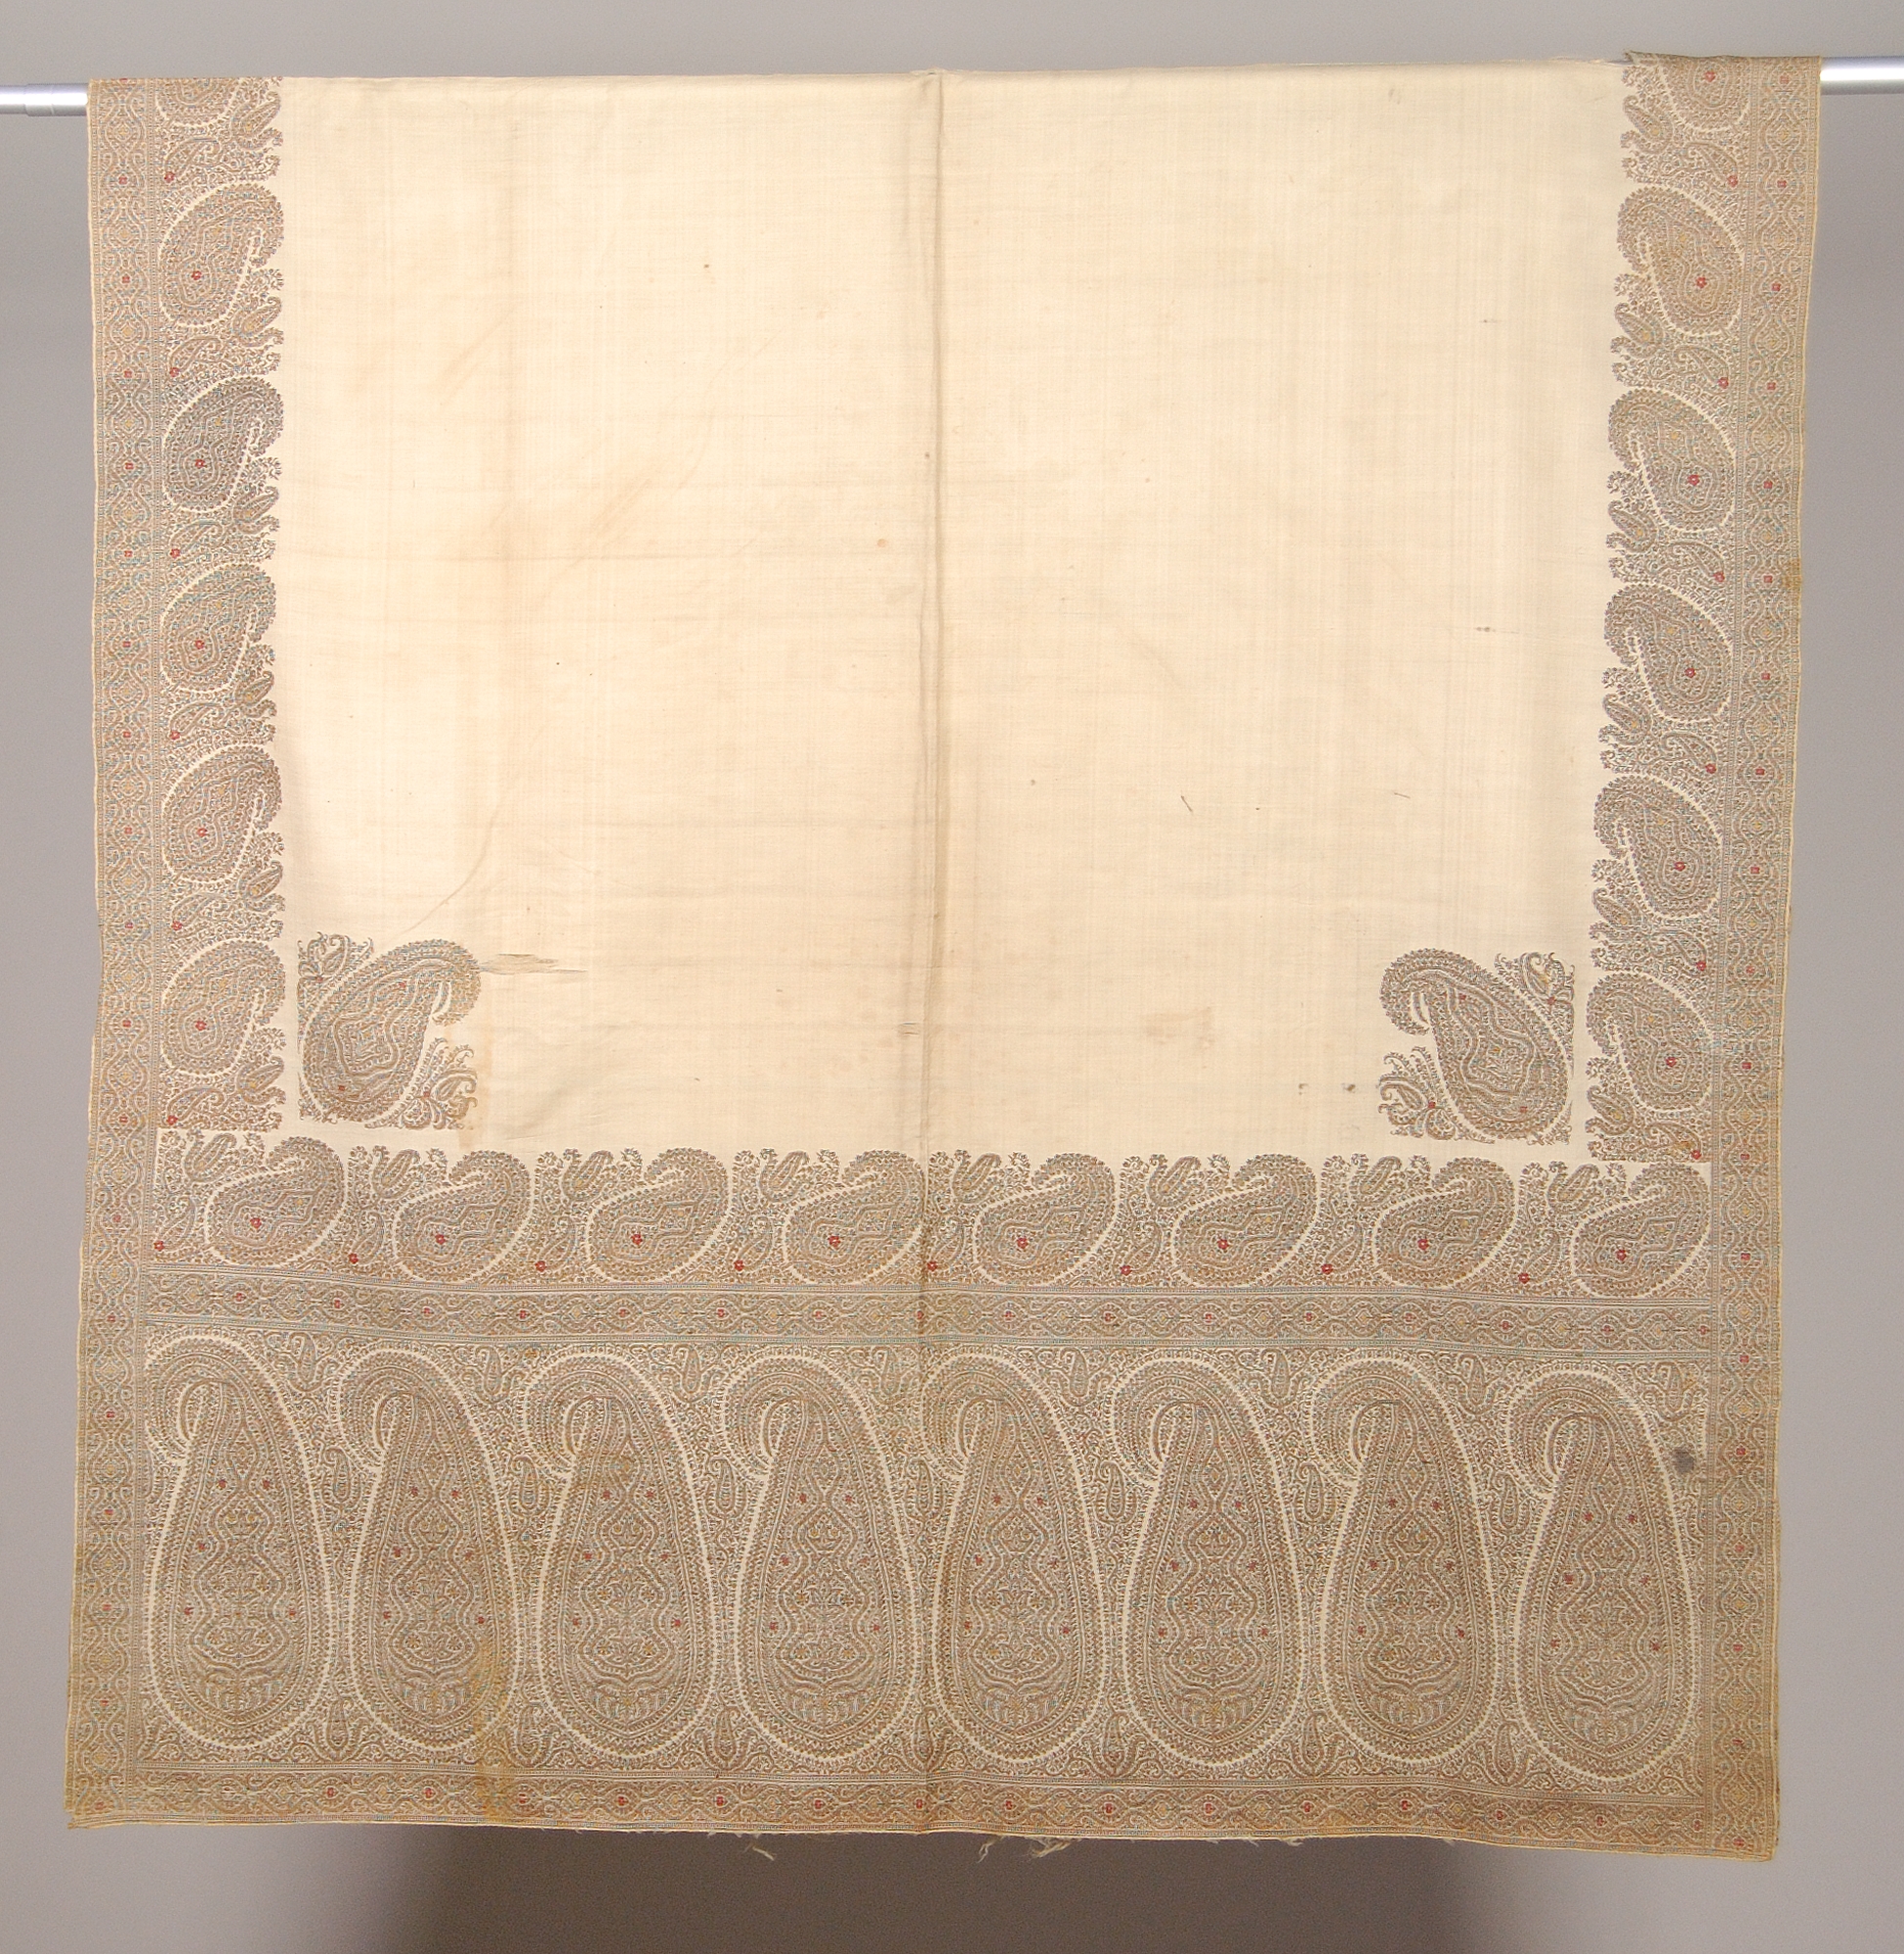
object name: shawl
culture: scottish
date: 1860-1880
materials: wool